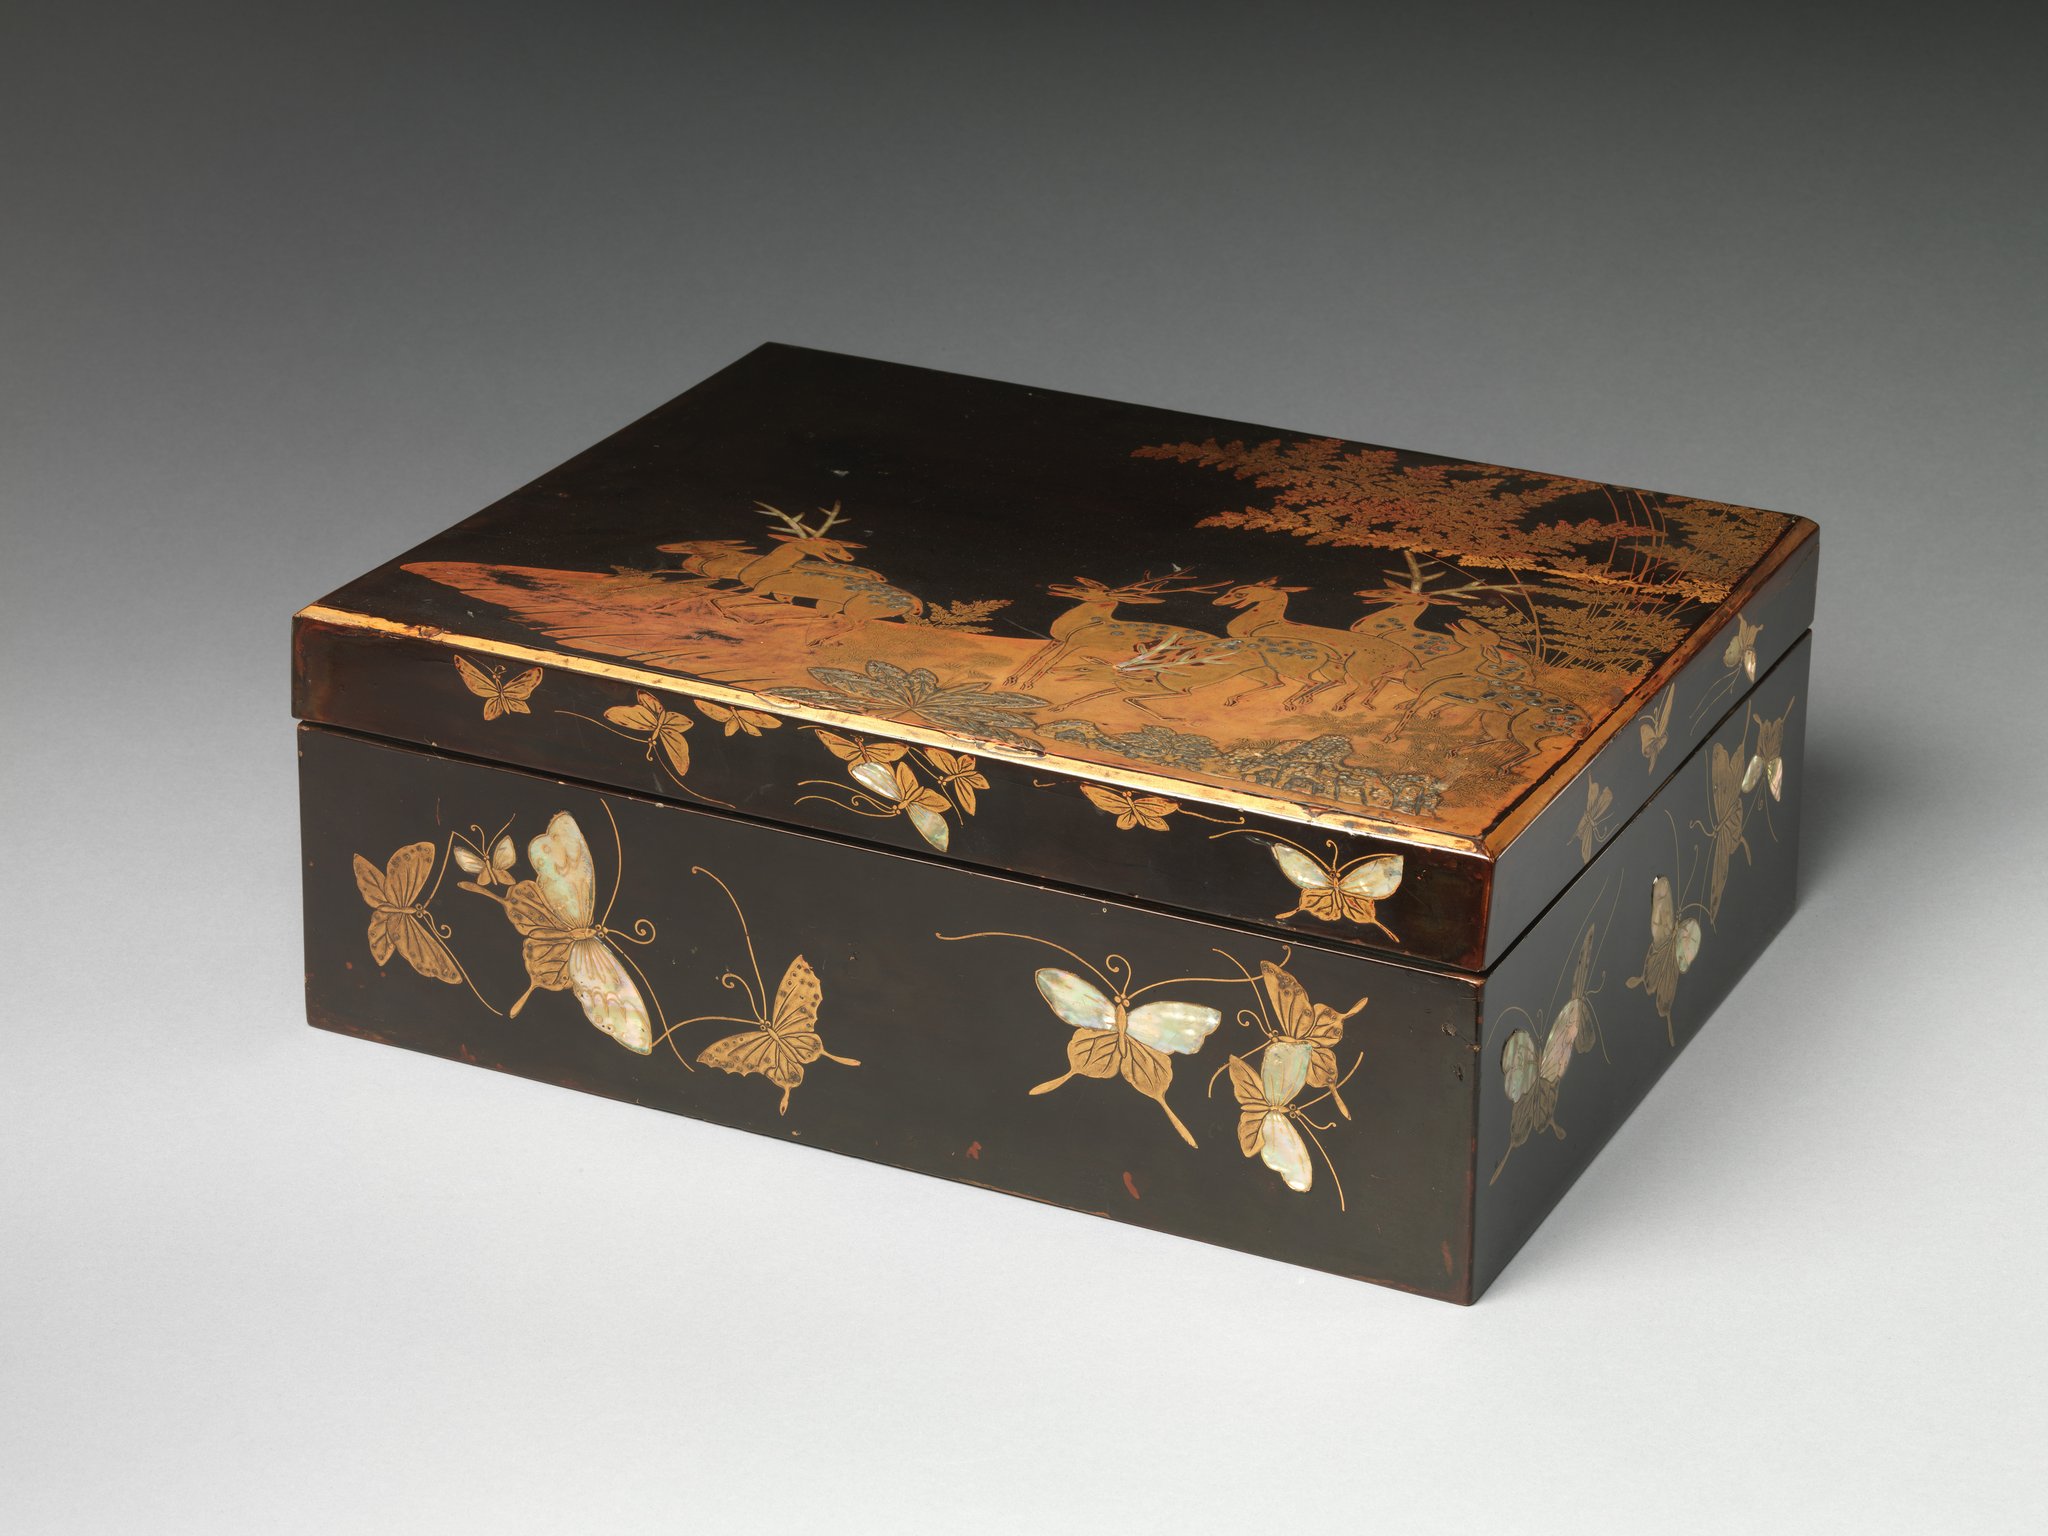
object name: box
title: Document Box (Ryōshibako) with Deer and Butterflies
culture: japanese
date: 1601-1700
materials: foil, gold, pearl, silver, wood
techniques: hiramakie, inlay, lacquer, maki-e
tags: deer,butterflies,plants